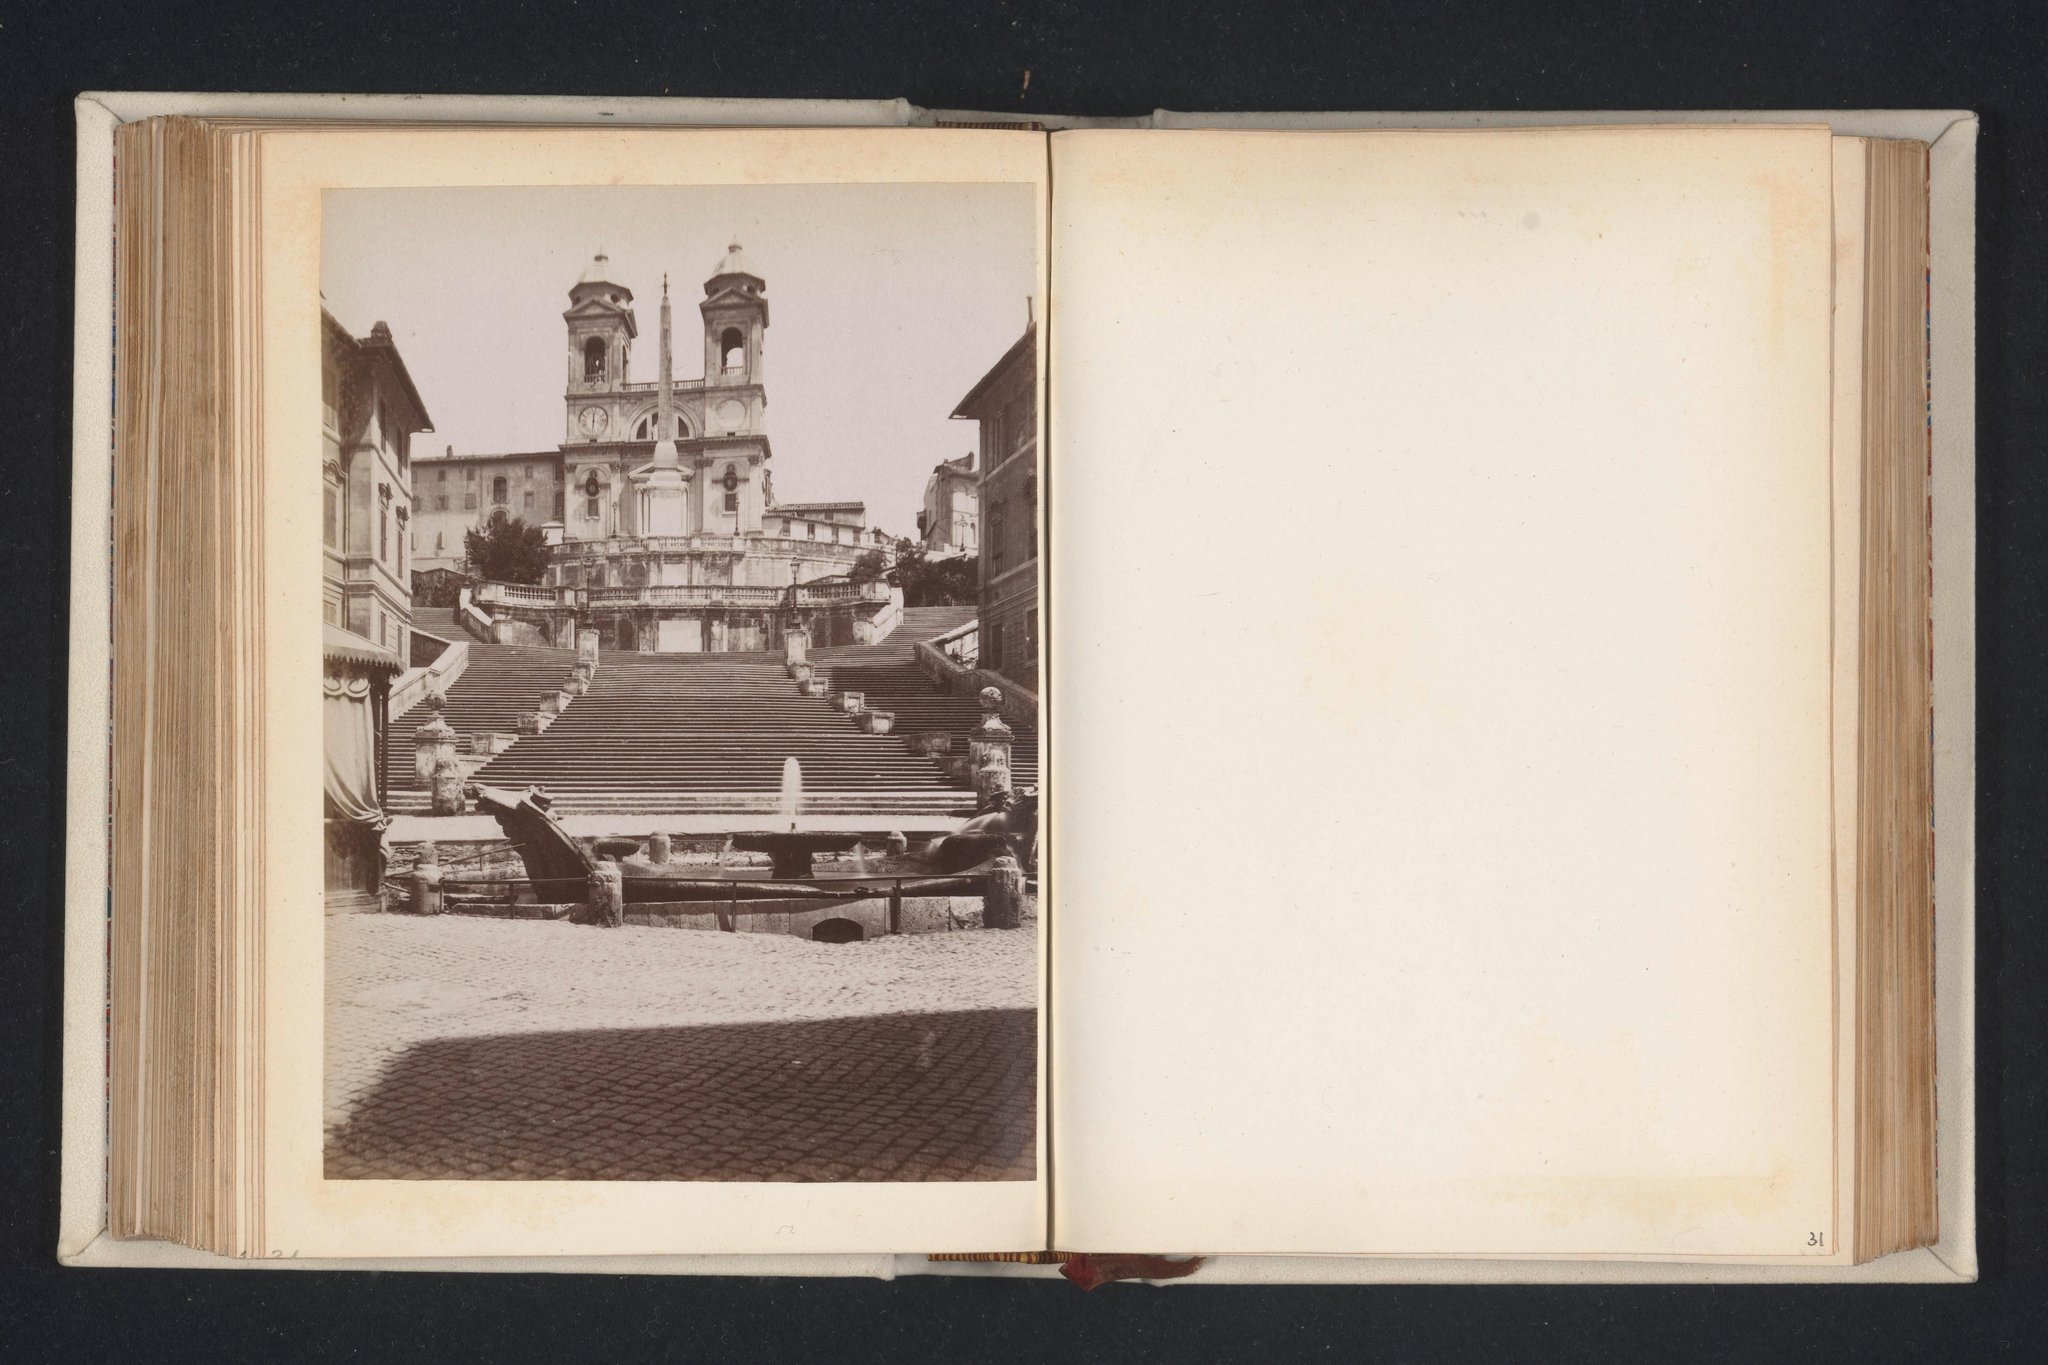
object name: photograph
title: Gezicht op de Spaanse trappen in Rome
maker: Anonymous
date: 1850-1860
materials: photographic support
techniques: albumen print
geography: rome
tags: square, place, circus, etc.